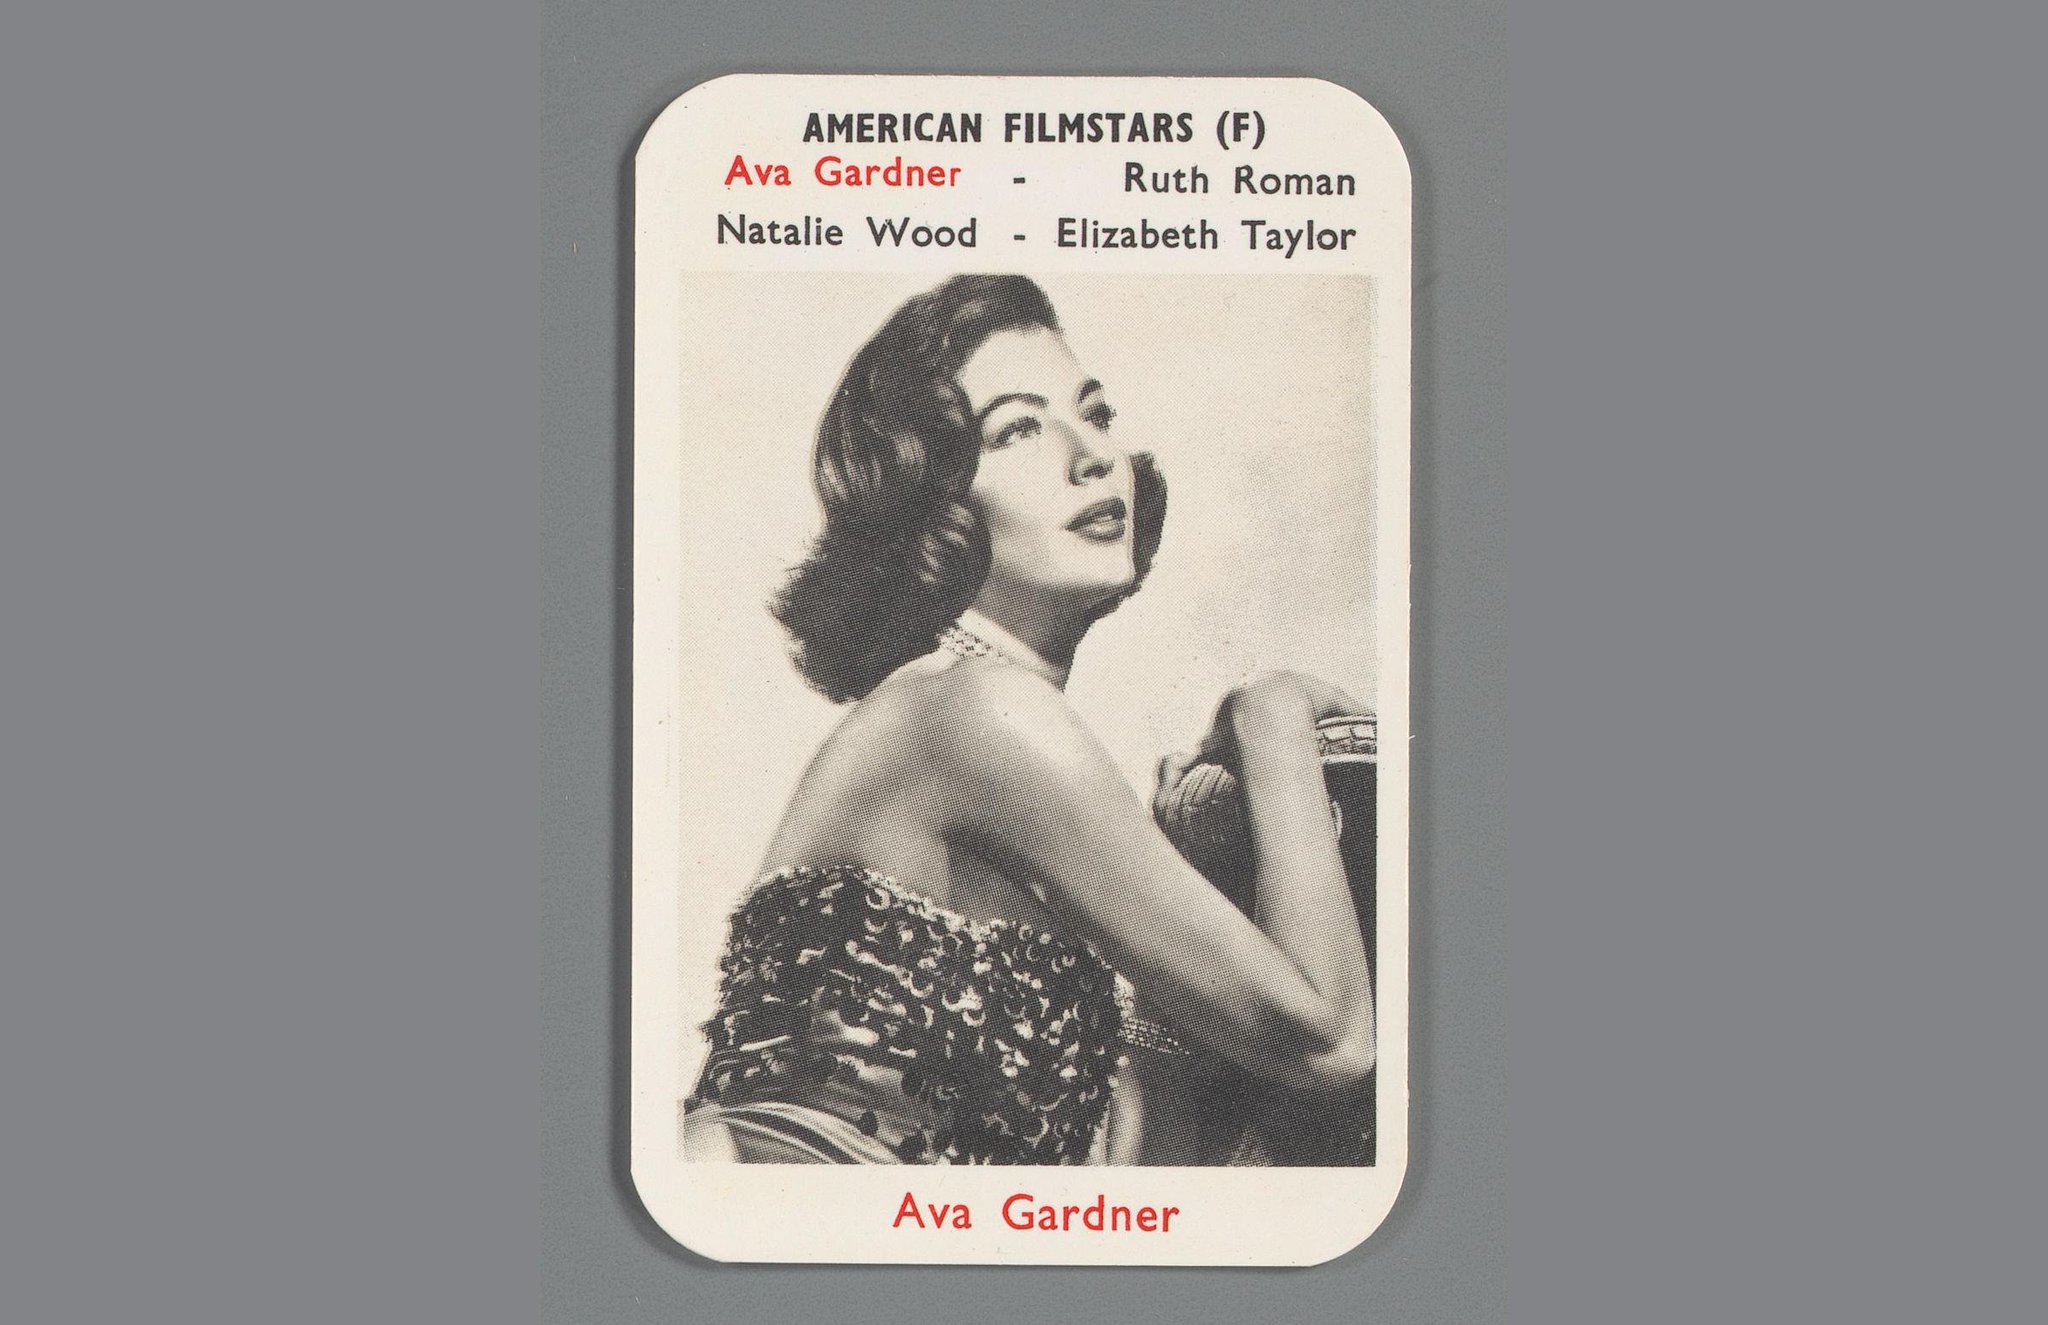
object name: playing card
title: American Filmstars (F)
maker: Anonymous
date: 1960-1970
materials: paper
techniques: autotype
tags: portrait of actor, actress